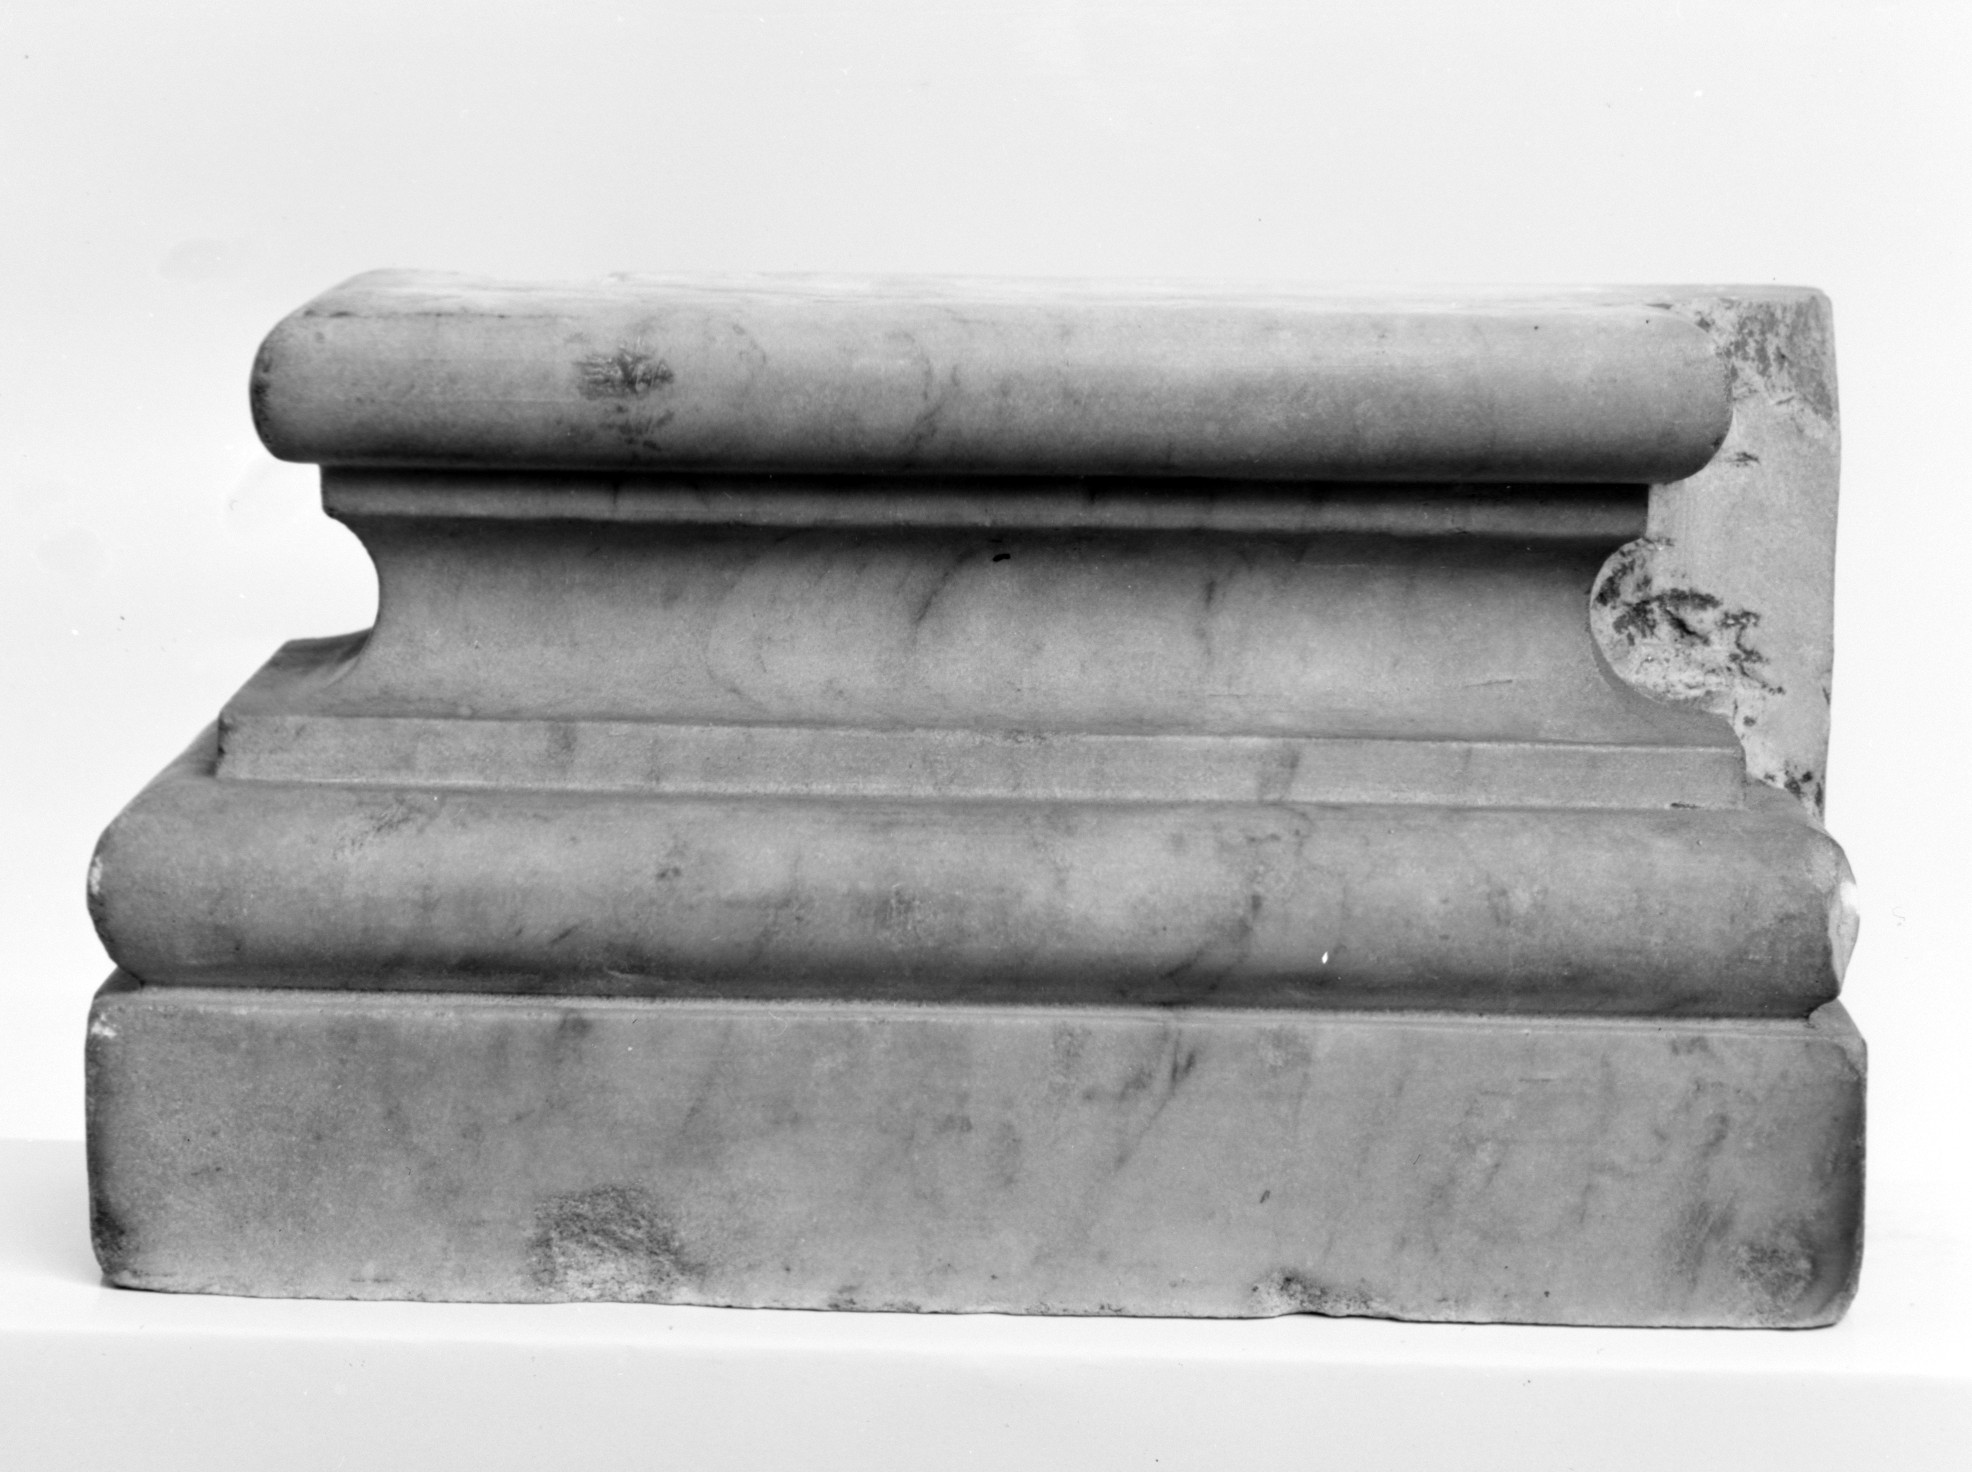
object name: pilaster base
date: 1467-1533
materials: marble